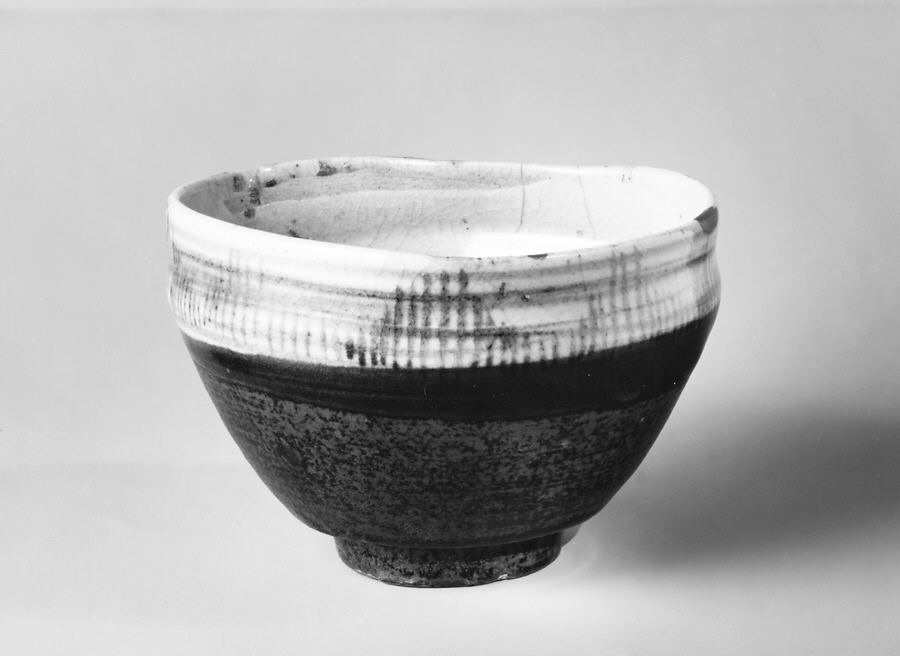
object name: teabowl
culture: japanese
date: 1601-1866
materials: glaze, iron, porcelain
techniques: underglaze